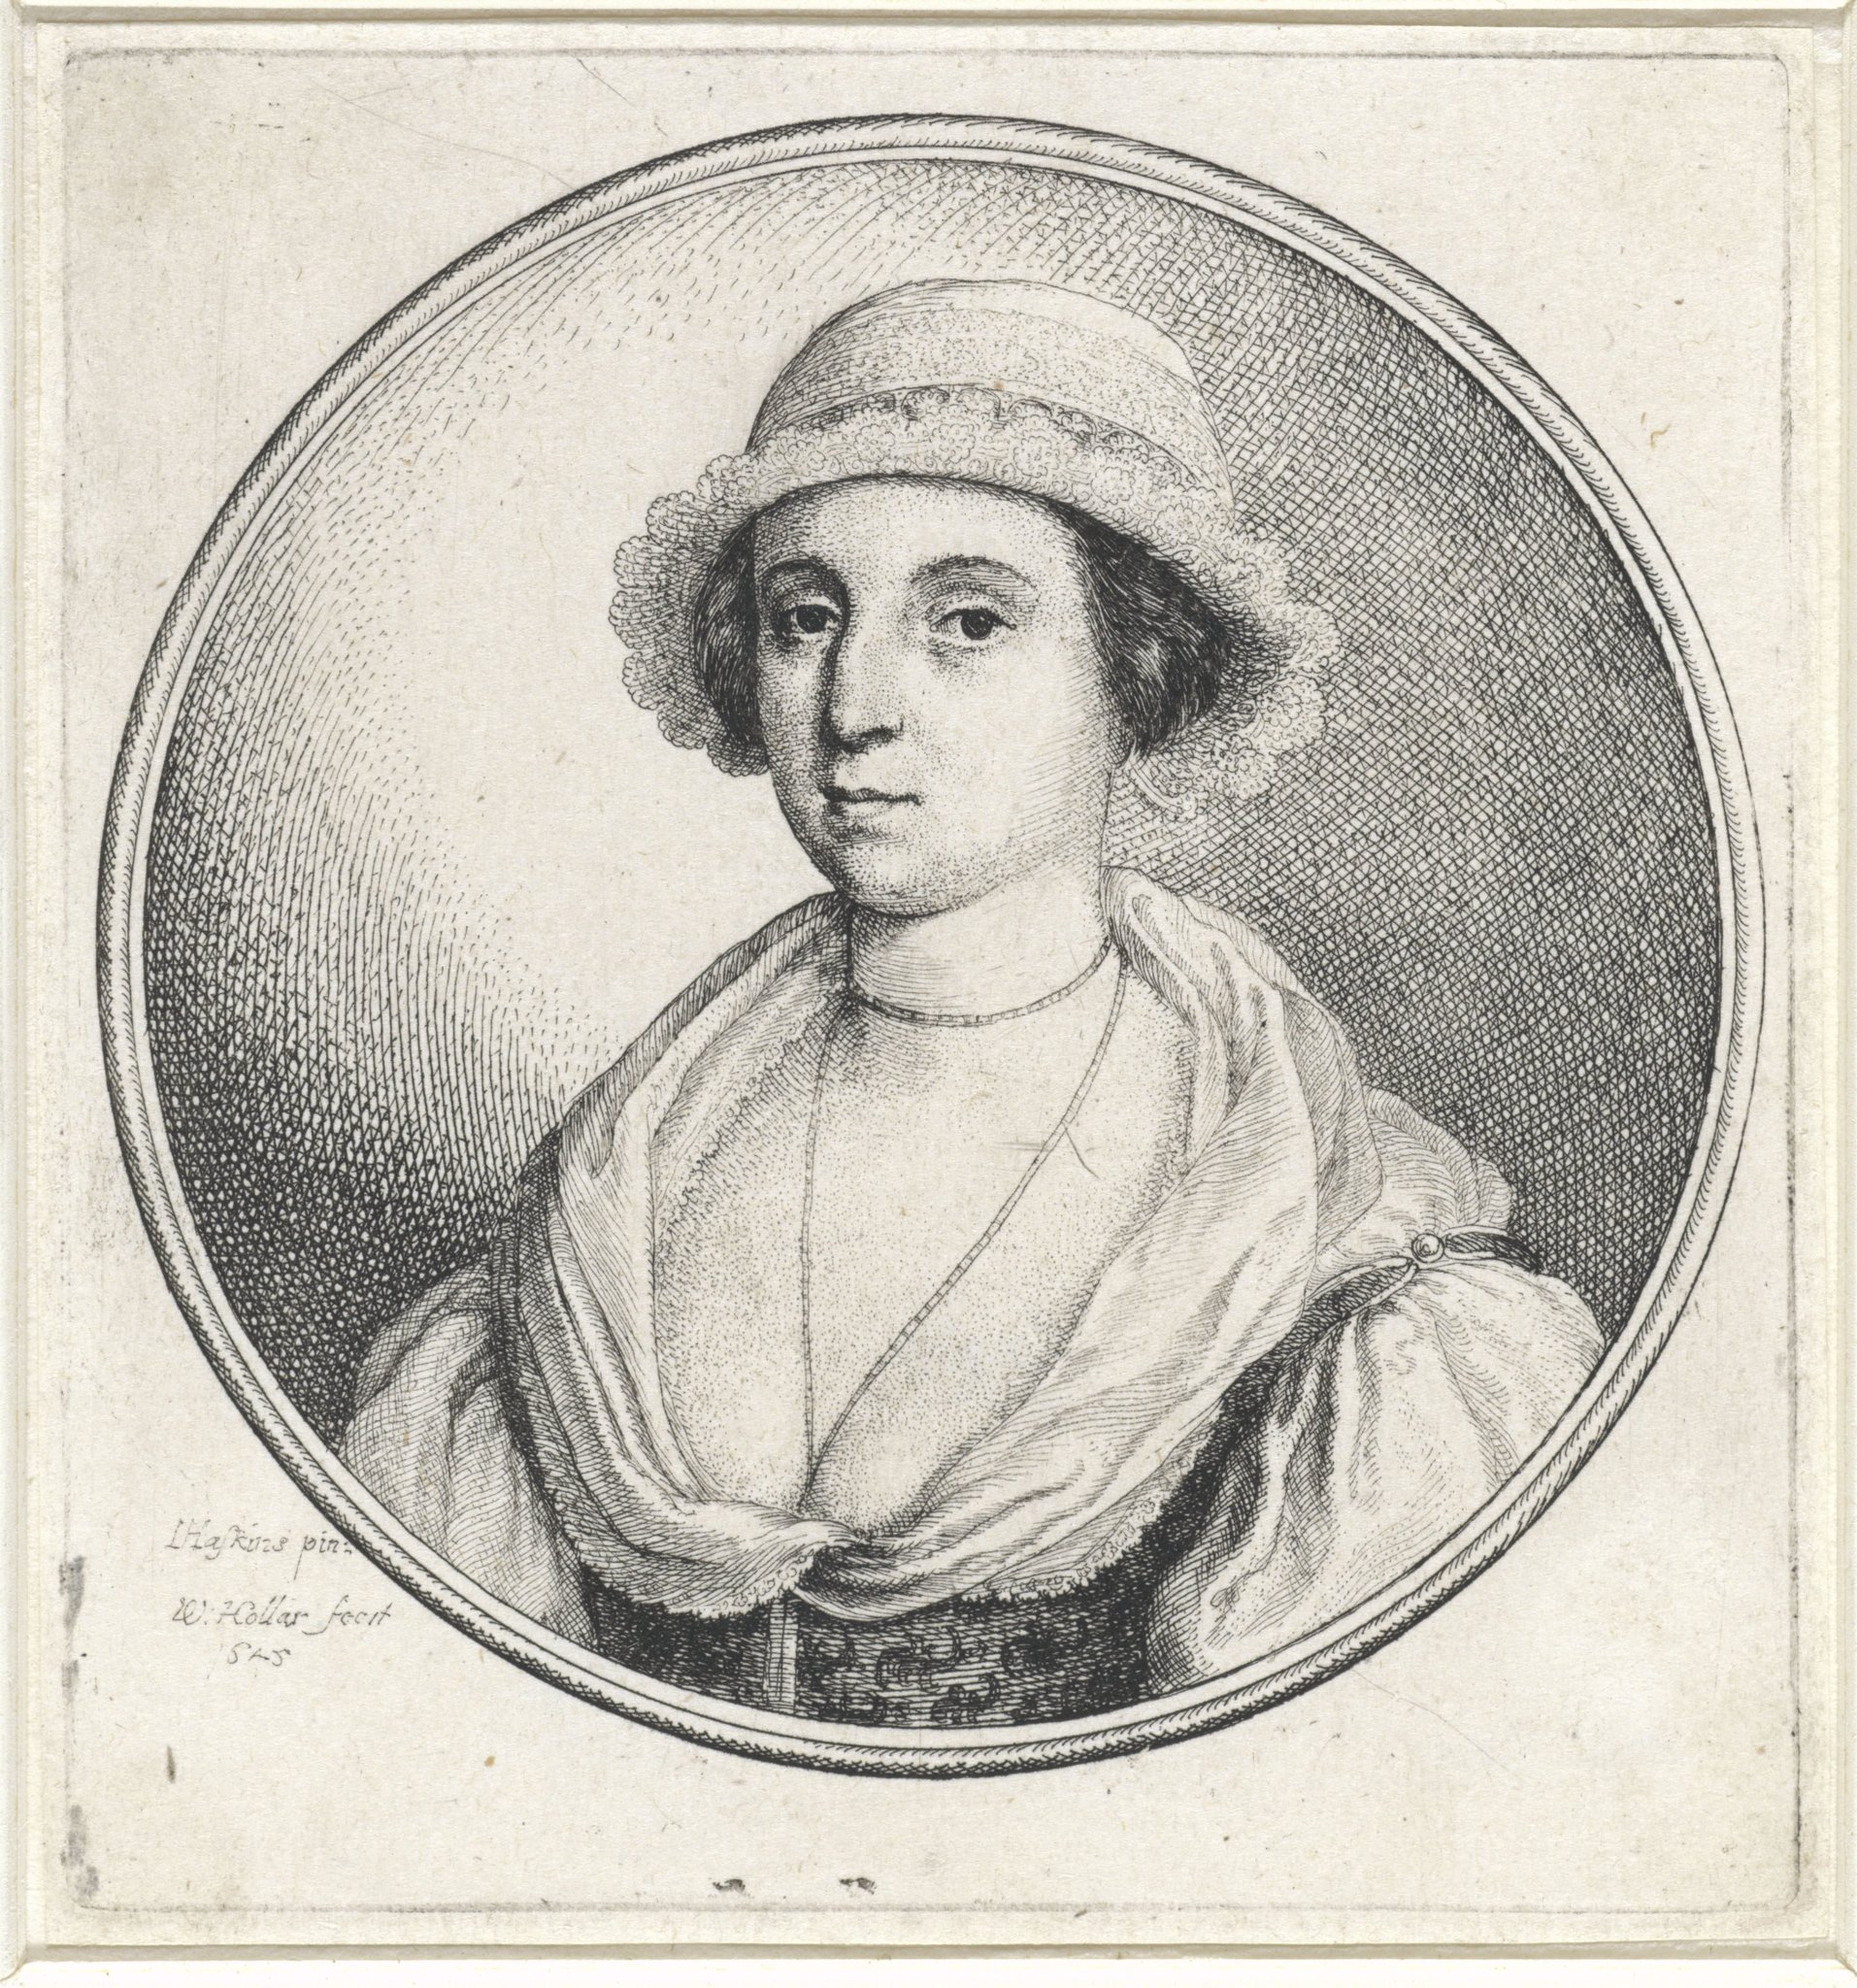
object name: print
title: Vrouwenbusten in ronde lijsten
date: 1645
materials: paper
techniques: etching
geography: antwerp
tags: anonymous historical person portrayed alone - bb - woman, head-gear: cap (+ women's clothes)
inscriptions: collector's mark: Lugt 654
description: De prent maakt deel uit van een 23-delige serie met verschillende vrouwenbusten in ronde lijsten.